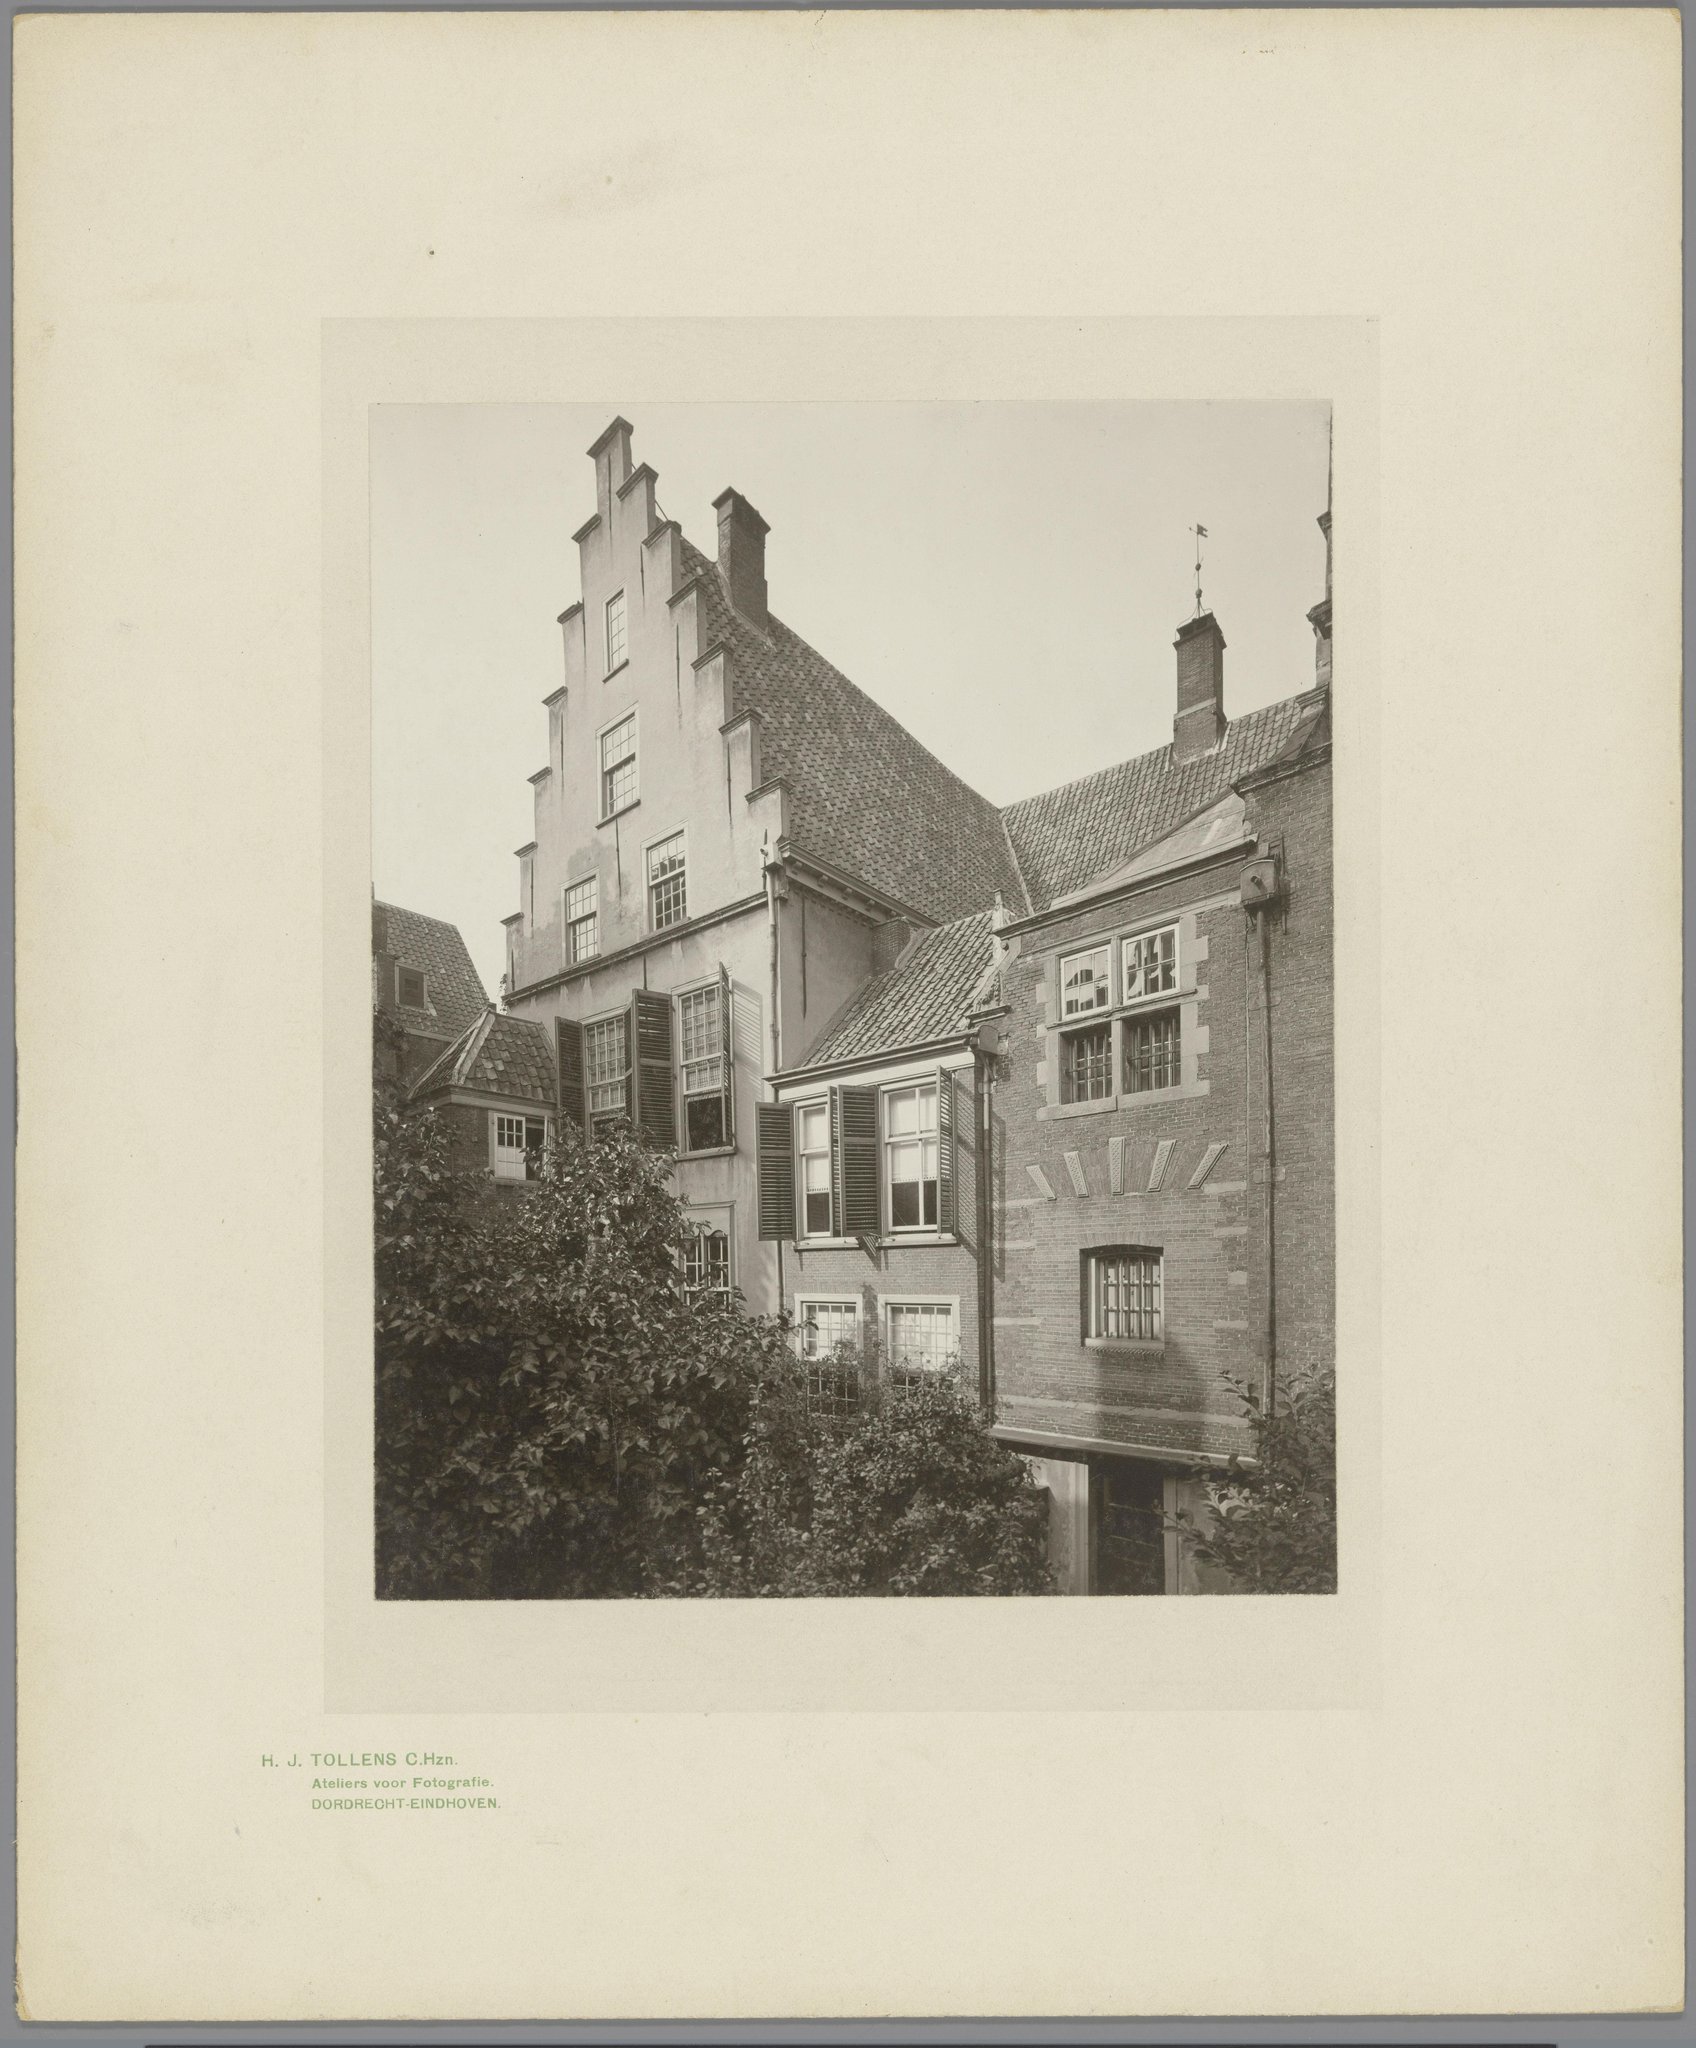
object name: photograph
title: Achterkant van het Rijnlandshuis te Leiden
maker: henricus jacobus tollens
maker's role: painter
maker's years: 1864-1936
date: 1880-1910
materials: cardboard, photographic support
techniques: collodion silver print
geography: leiden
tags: governmental and representative bodies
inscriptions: annotation: ‘No.3/ Leiden/ achterkant Gemeenlandshuis’, inscription: ‘H.J. Tollens C. Hzn./ Ateliers voor Fotografie/ Dordrecht-Eindhoven’, number: ‘116’